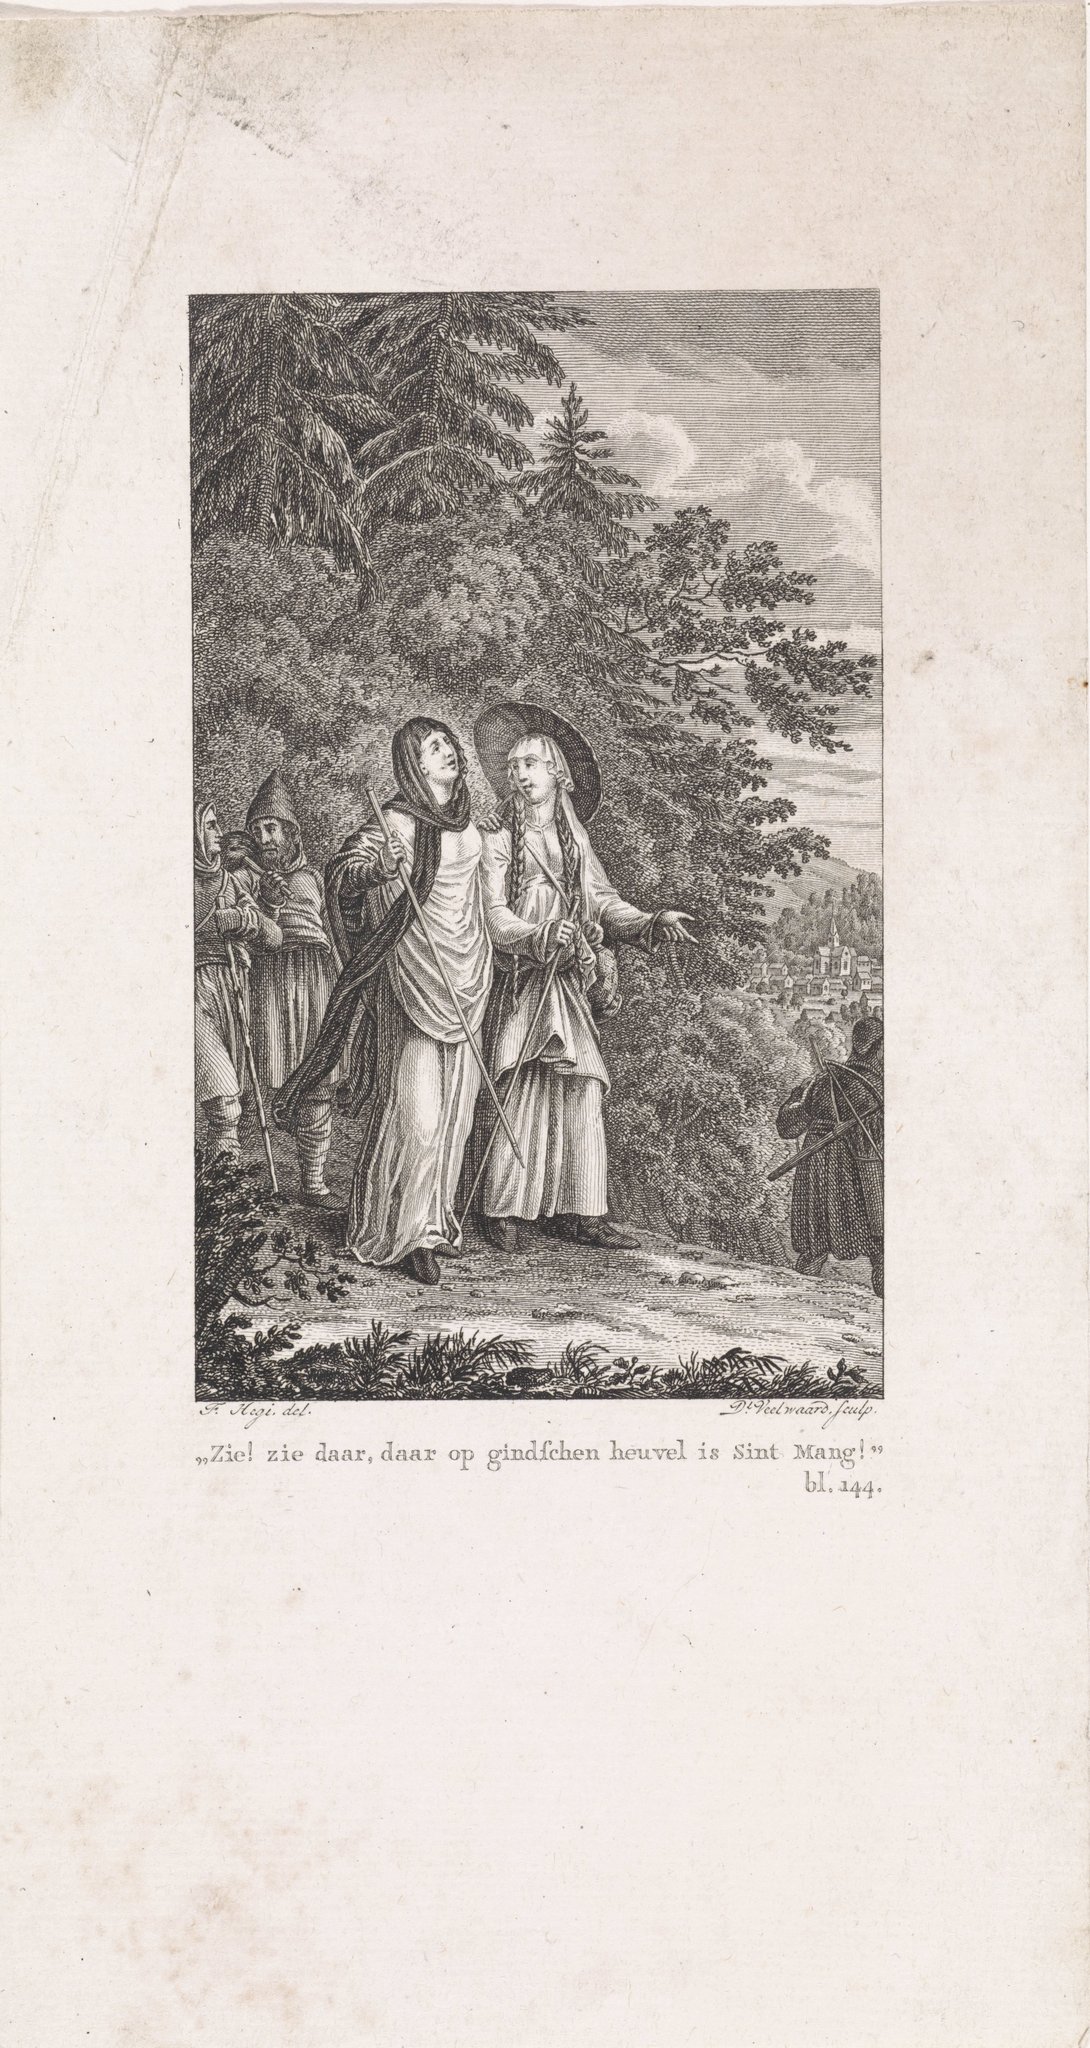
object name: print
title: Twee vrouwelijke pelgrims op een bospad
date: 1776-1851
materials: paper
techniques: engraving, etching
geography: amsterdam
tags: pilgrimage, pilgrim(s) under way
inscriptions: collector's mark: Lugt 2228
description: Twee vrouwelijke pelgrims op een bospad, met achter en voor hen nog andere reizigers. rechtsonder: bl. 144.